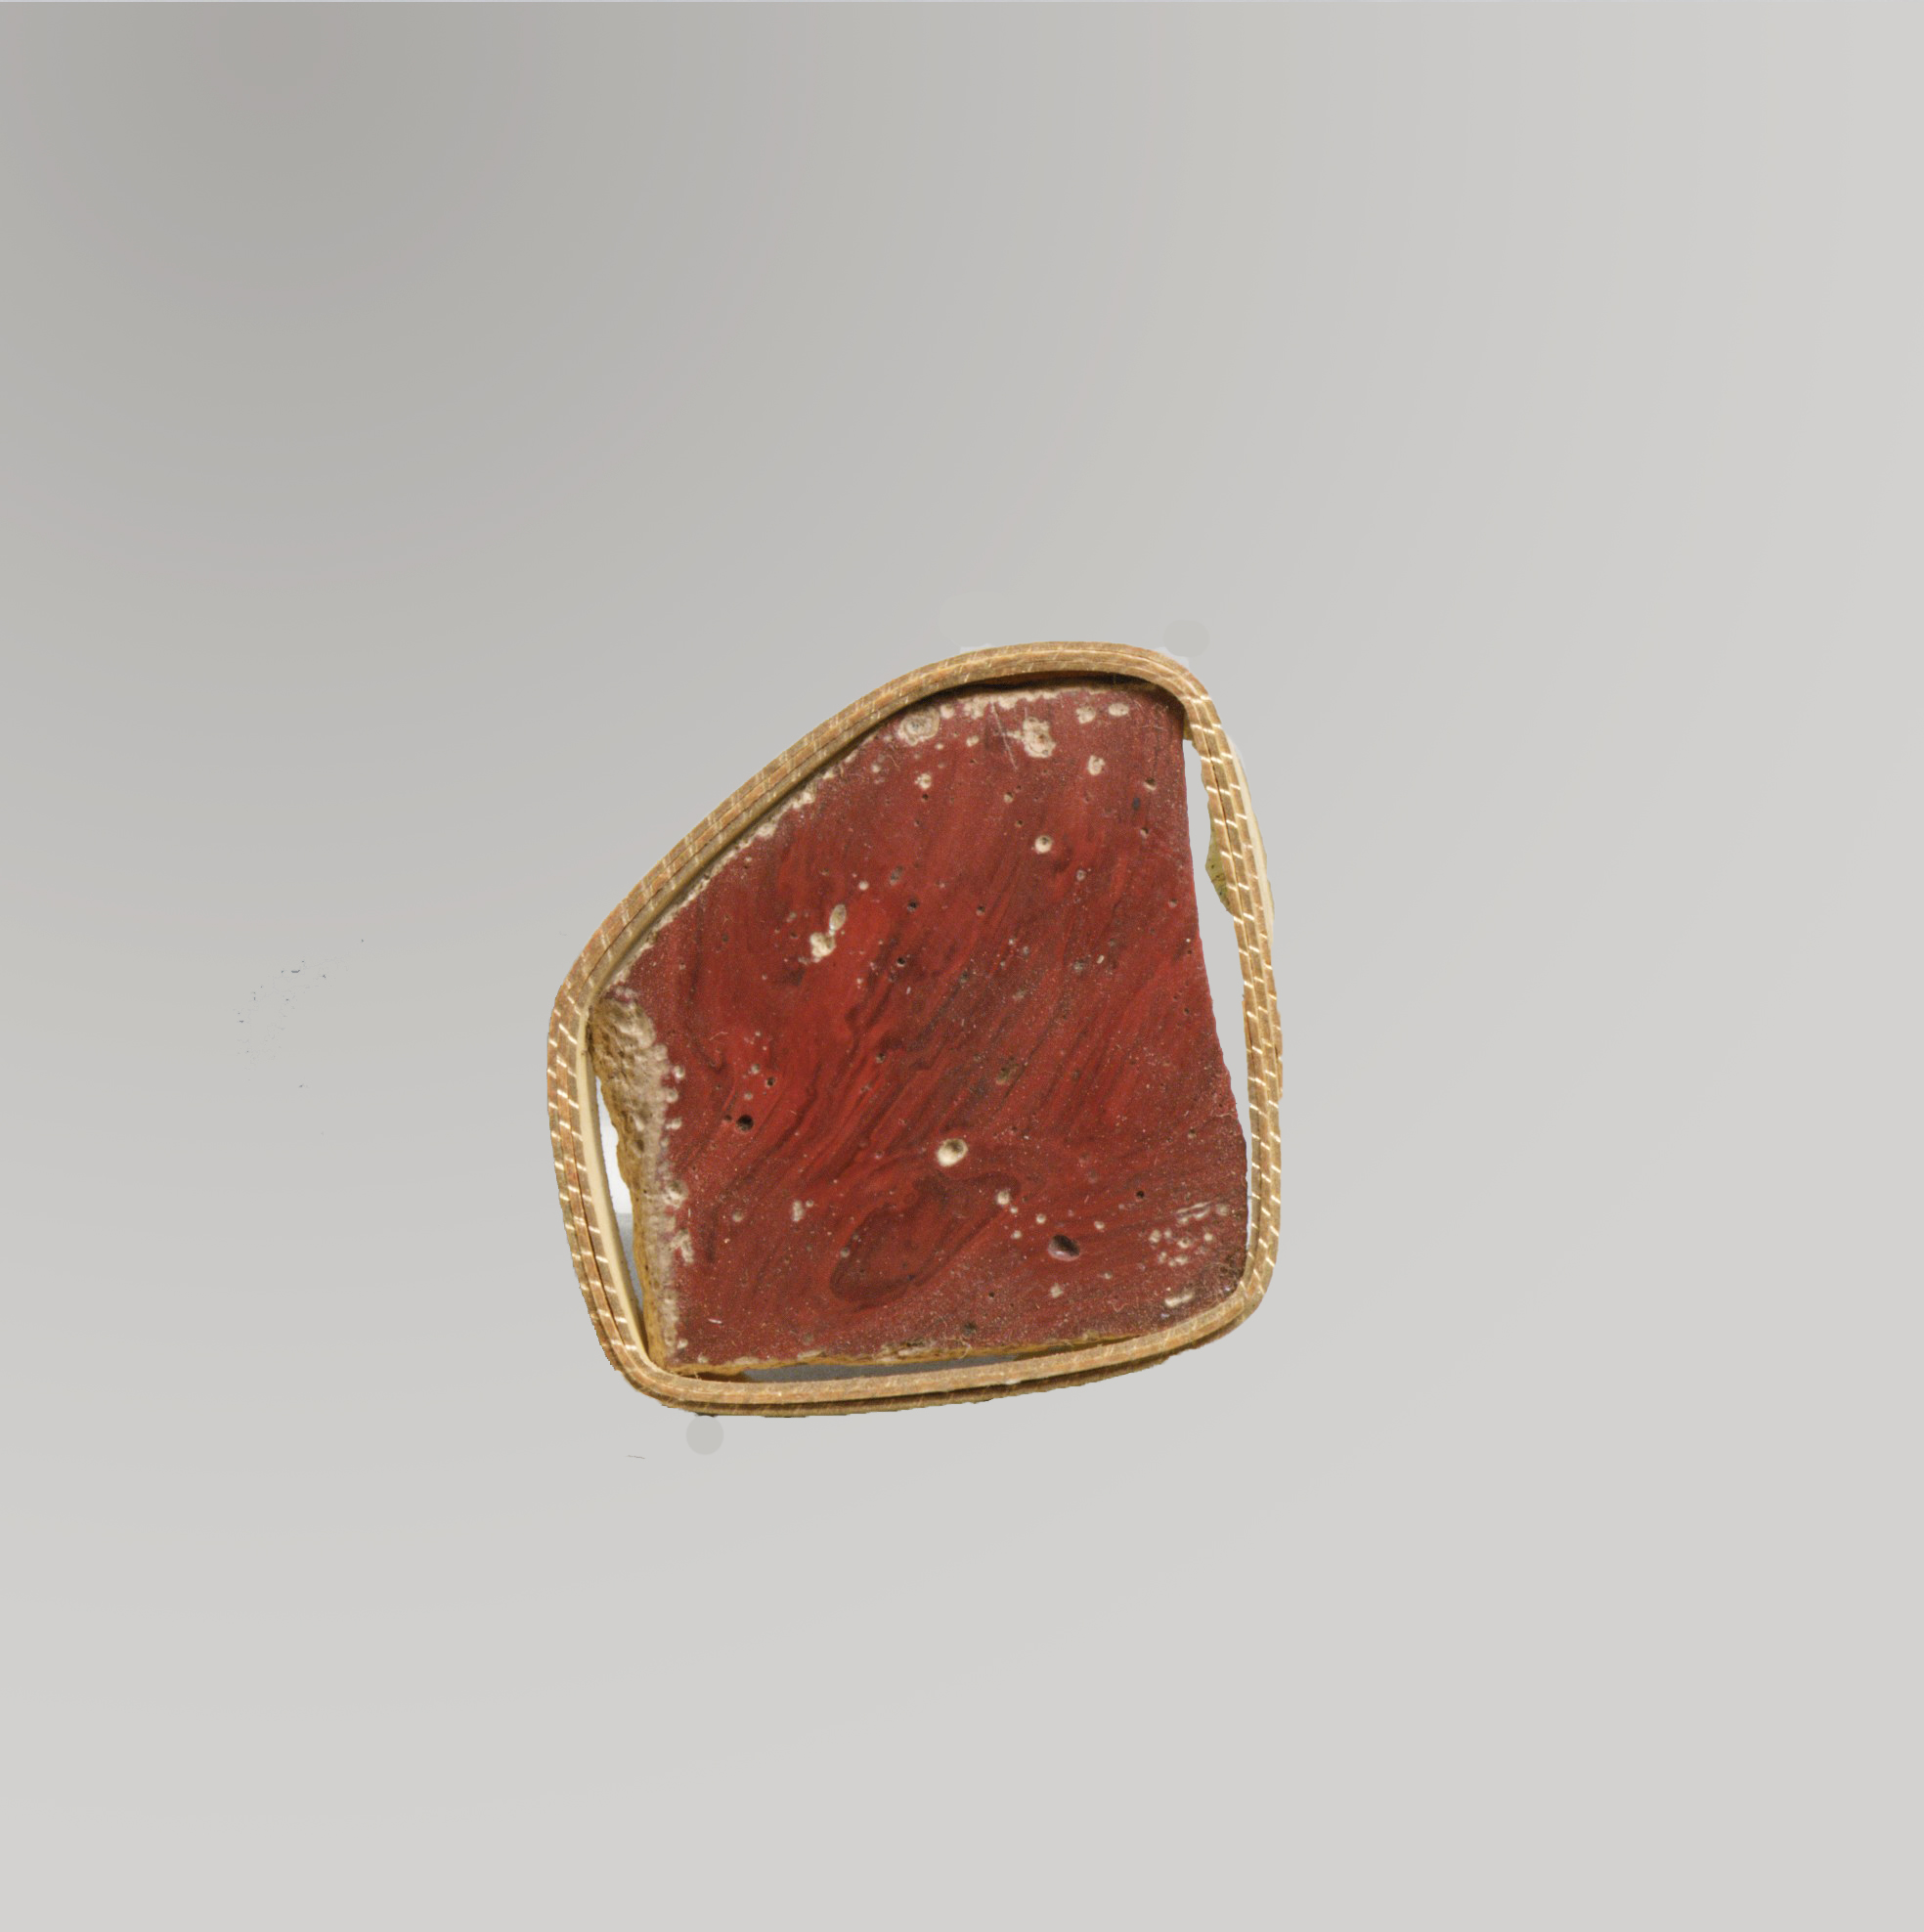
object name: fragment, mosaic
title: Glass mosaic inlay fragment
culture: roman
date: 34 BCE-33 CE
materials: glass